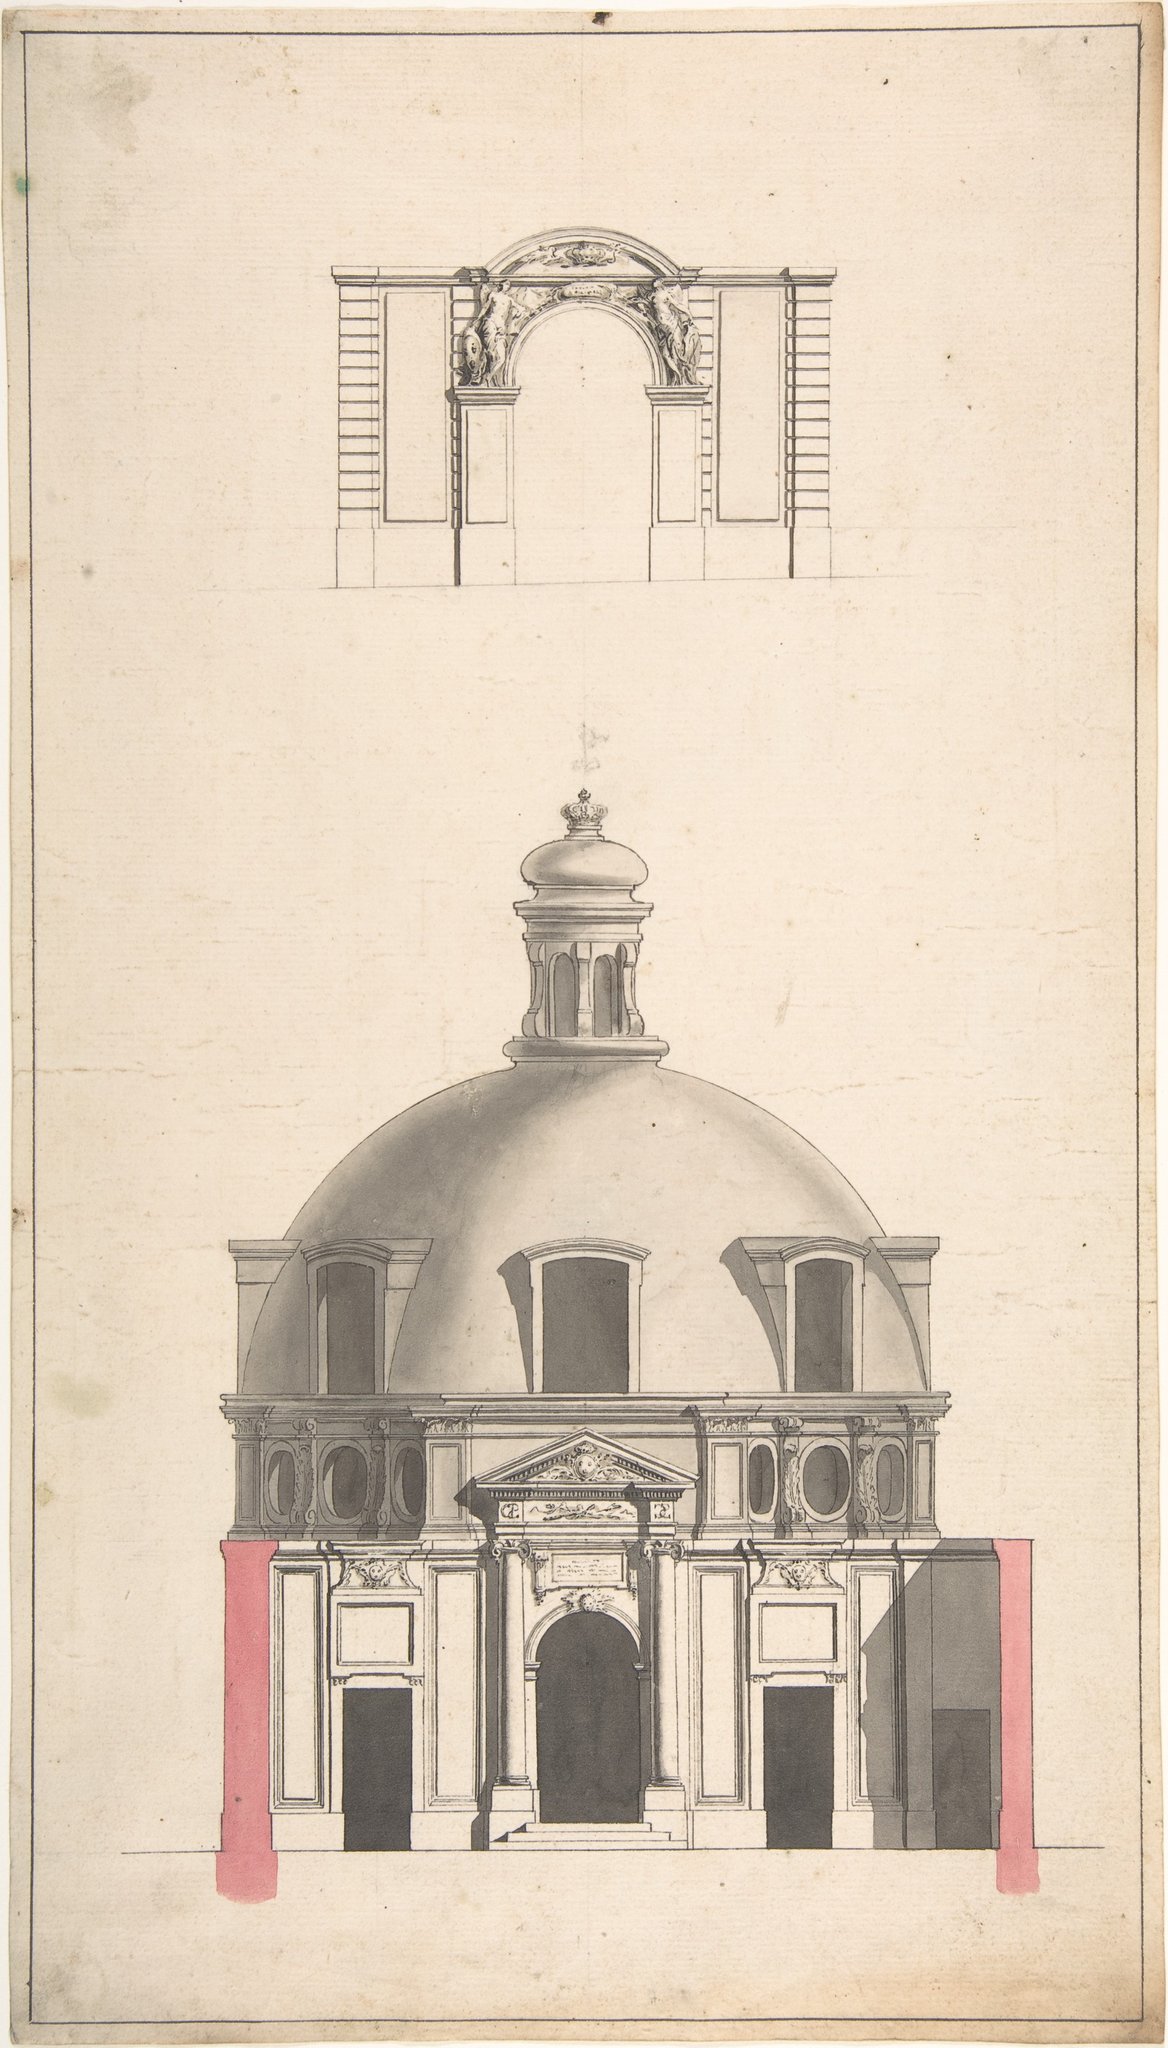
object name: drawing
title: Elevation of the Amphitheatre and Entrance Gate of the Collège des Chirugies, Paris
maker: jacques françois blondel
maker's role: artist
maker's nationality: french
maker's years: 1705-1774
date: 1752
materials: chalk, graphite, ink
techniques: brush, incising, pen, wash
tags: architecture,buildings